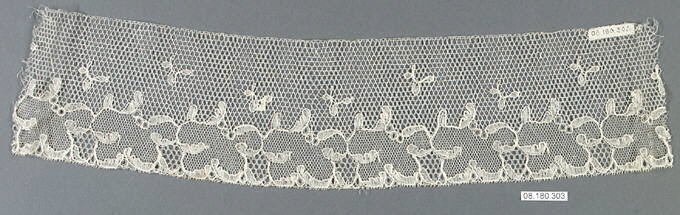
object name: fragment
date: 1801-1900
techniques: lace